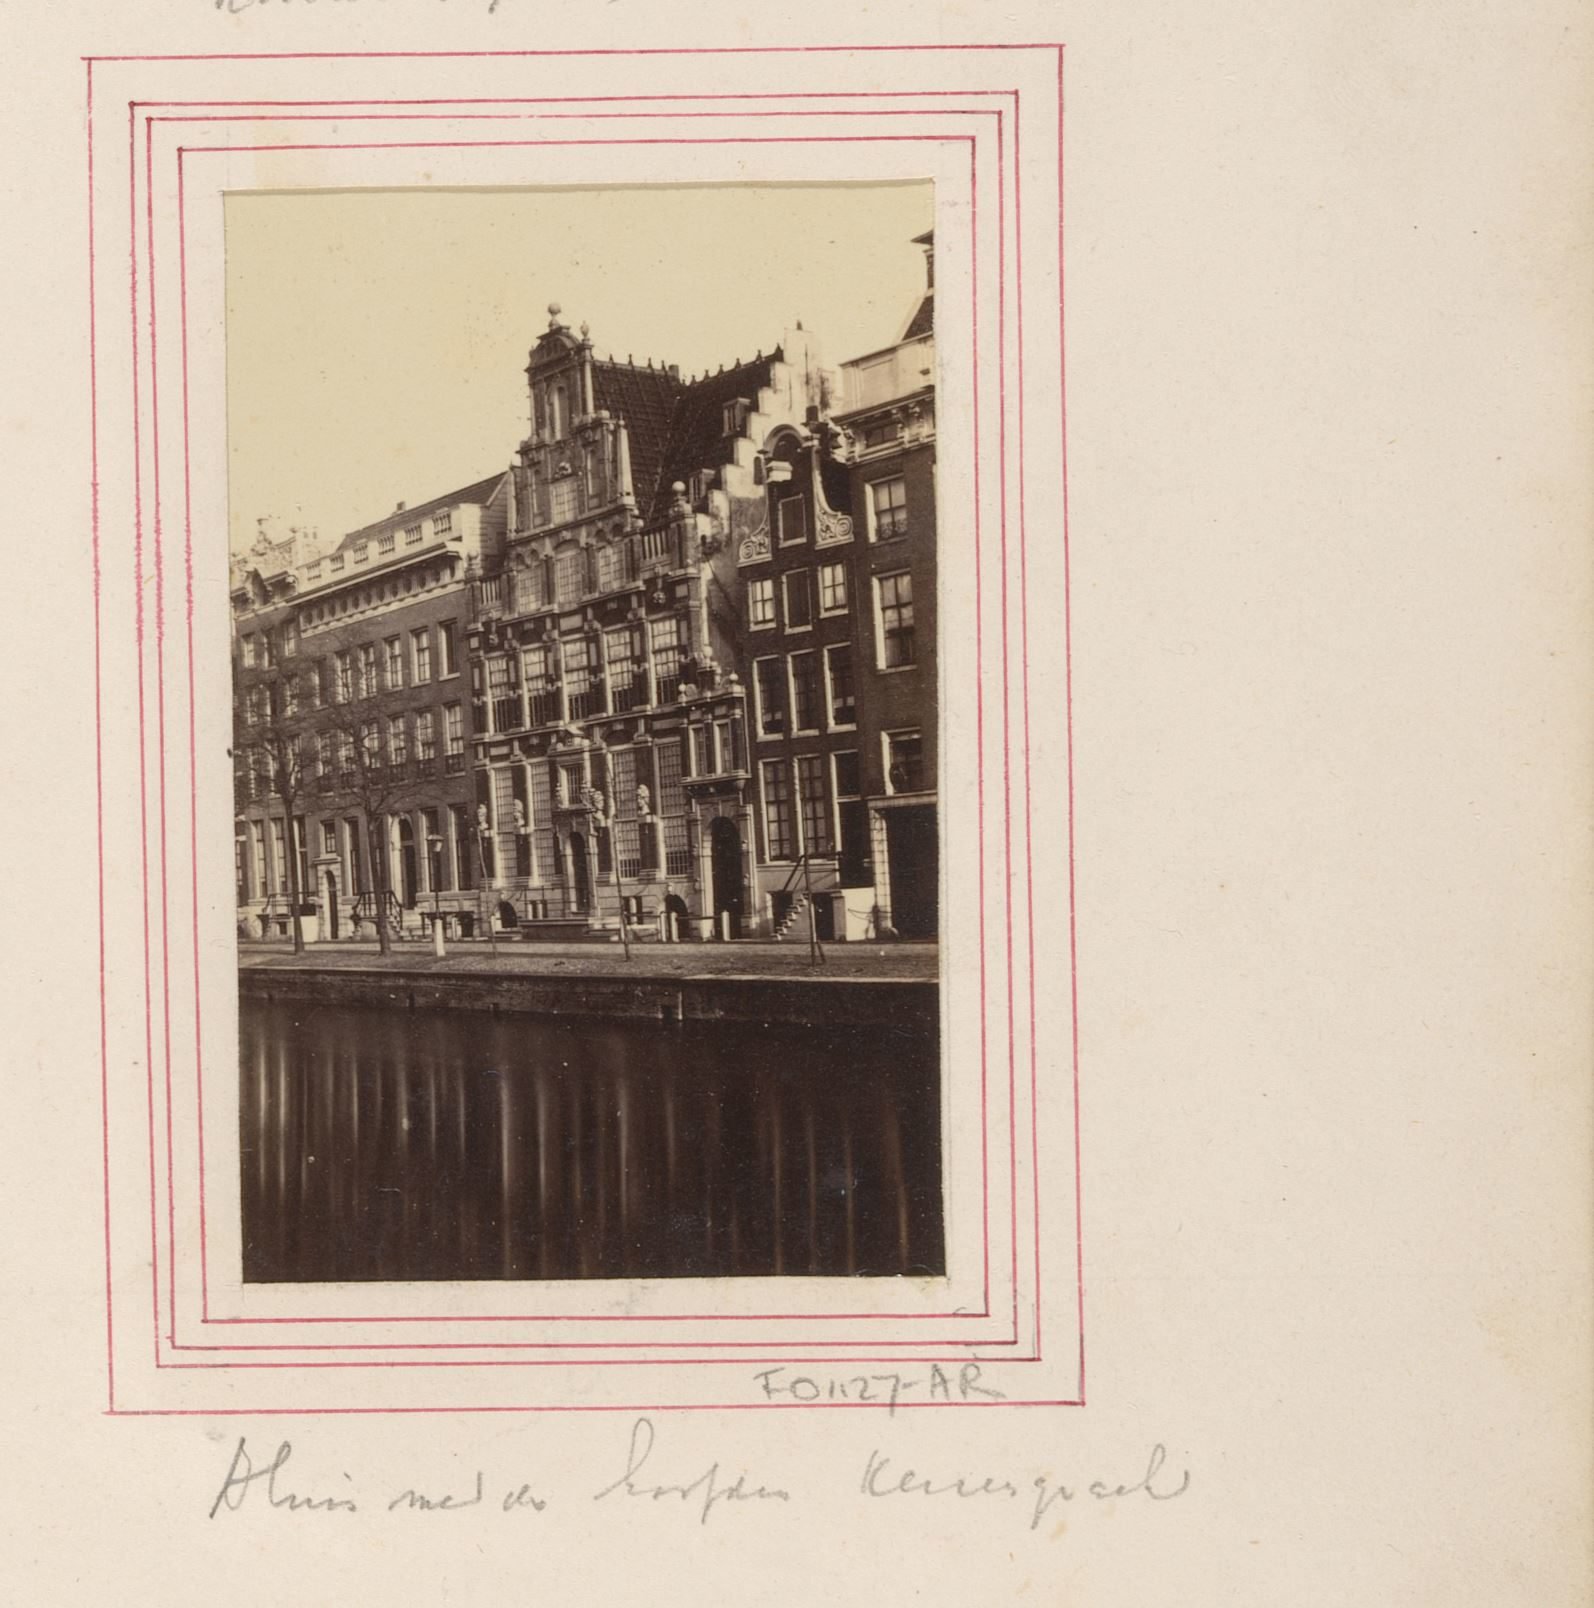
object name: photograph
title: Exterieur van het Huis met de Hoofden aan de Keizersgracht te Amsterdam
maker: pieter oosterhuis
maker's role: draughtsman, print maker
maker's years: 1816-1885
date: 1870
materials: photographic support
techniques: albumen print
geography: keizersgracht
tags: piece of sculpture, reproduction of a piece of sculpture, canals, waters (in city), façade (of house or building)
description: Onderdeel van Album met foto's en litho's van bezienswaardigheden in Noord- en Zuid-Hollandse steden, schilderijen en klederdrachten.